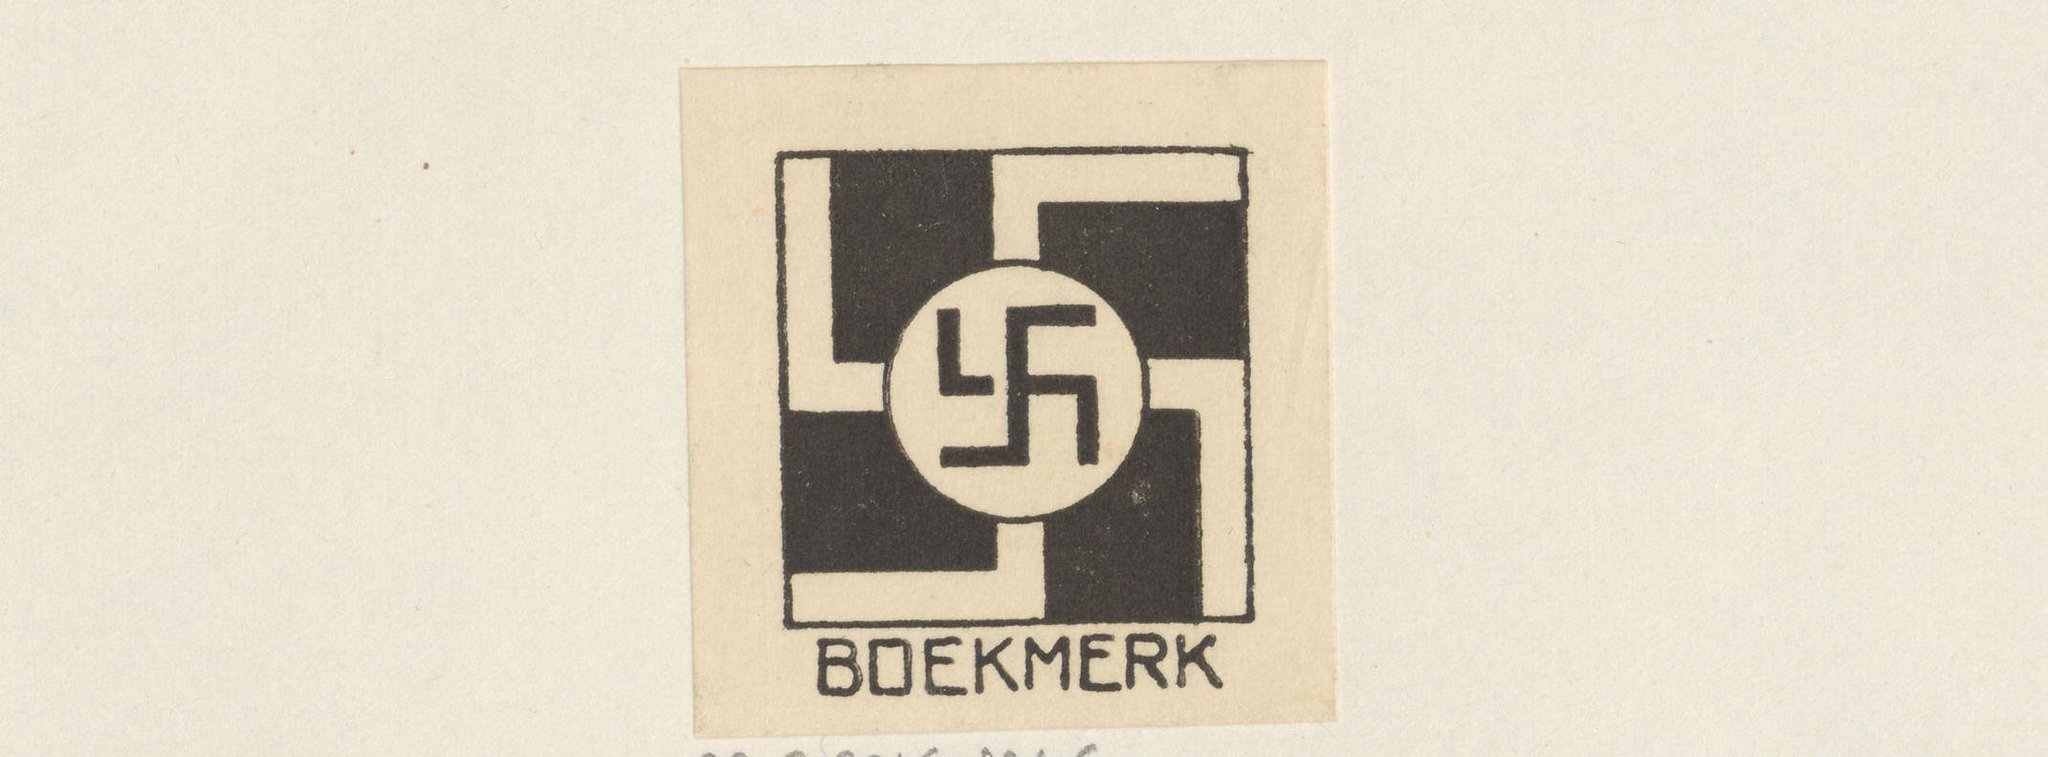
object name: bookplate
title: Ex libris van L.C. Heyting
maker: l.c. heyting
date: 1923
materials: paper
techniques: printing block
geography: netherlands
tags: l.c. heyting, specific forms of the cross: swastika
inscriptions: signature, date and inscription: ‘L.C. Heyting / ipse fecit 1923’